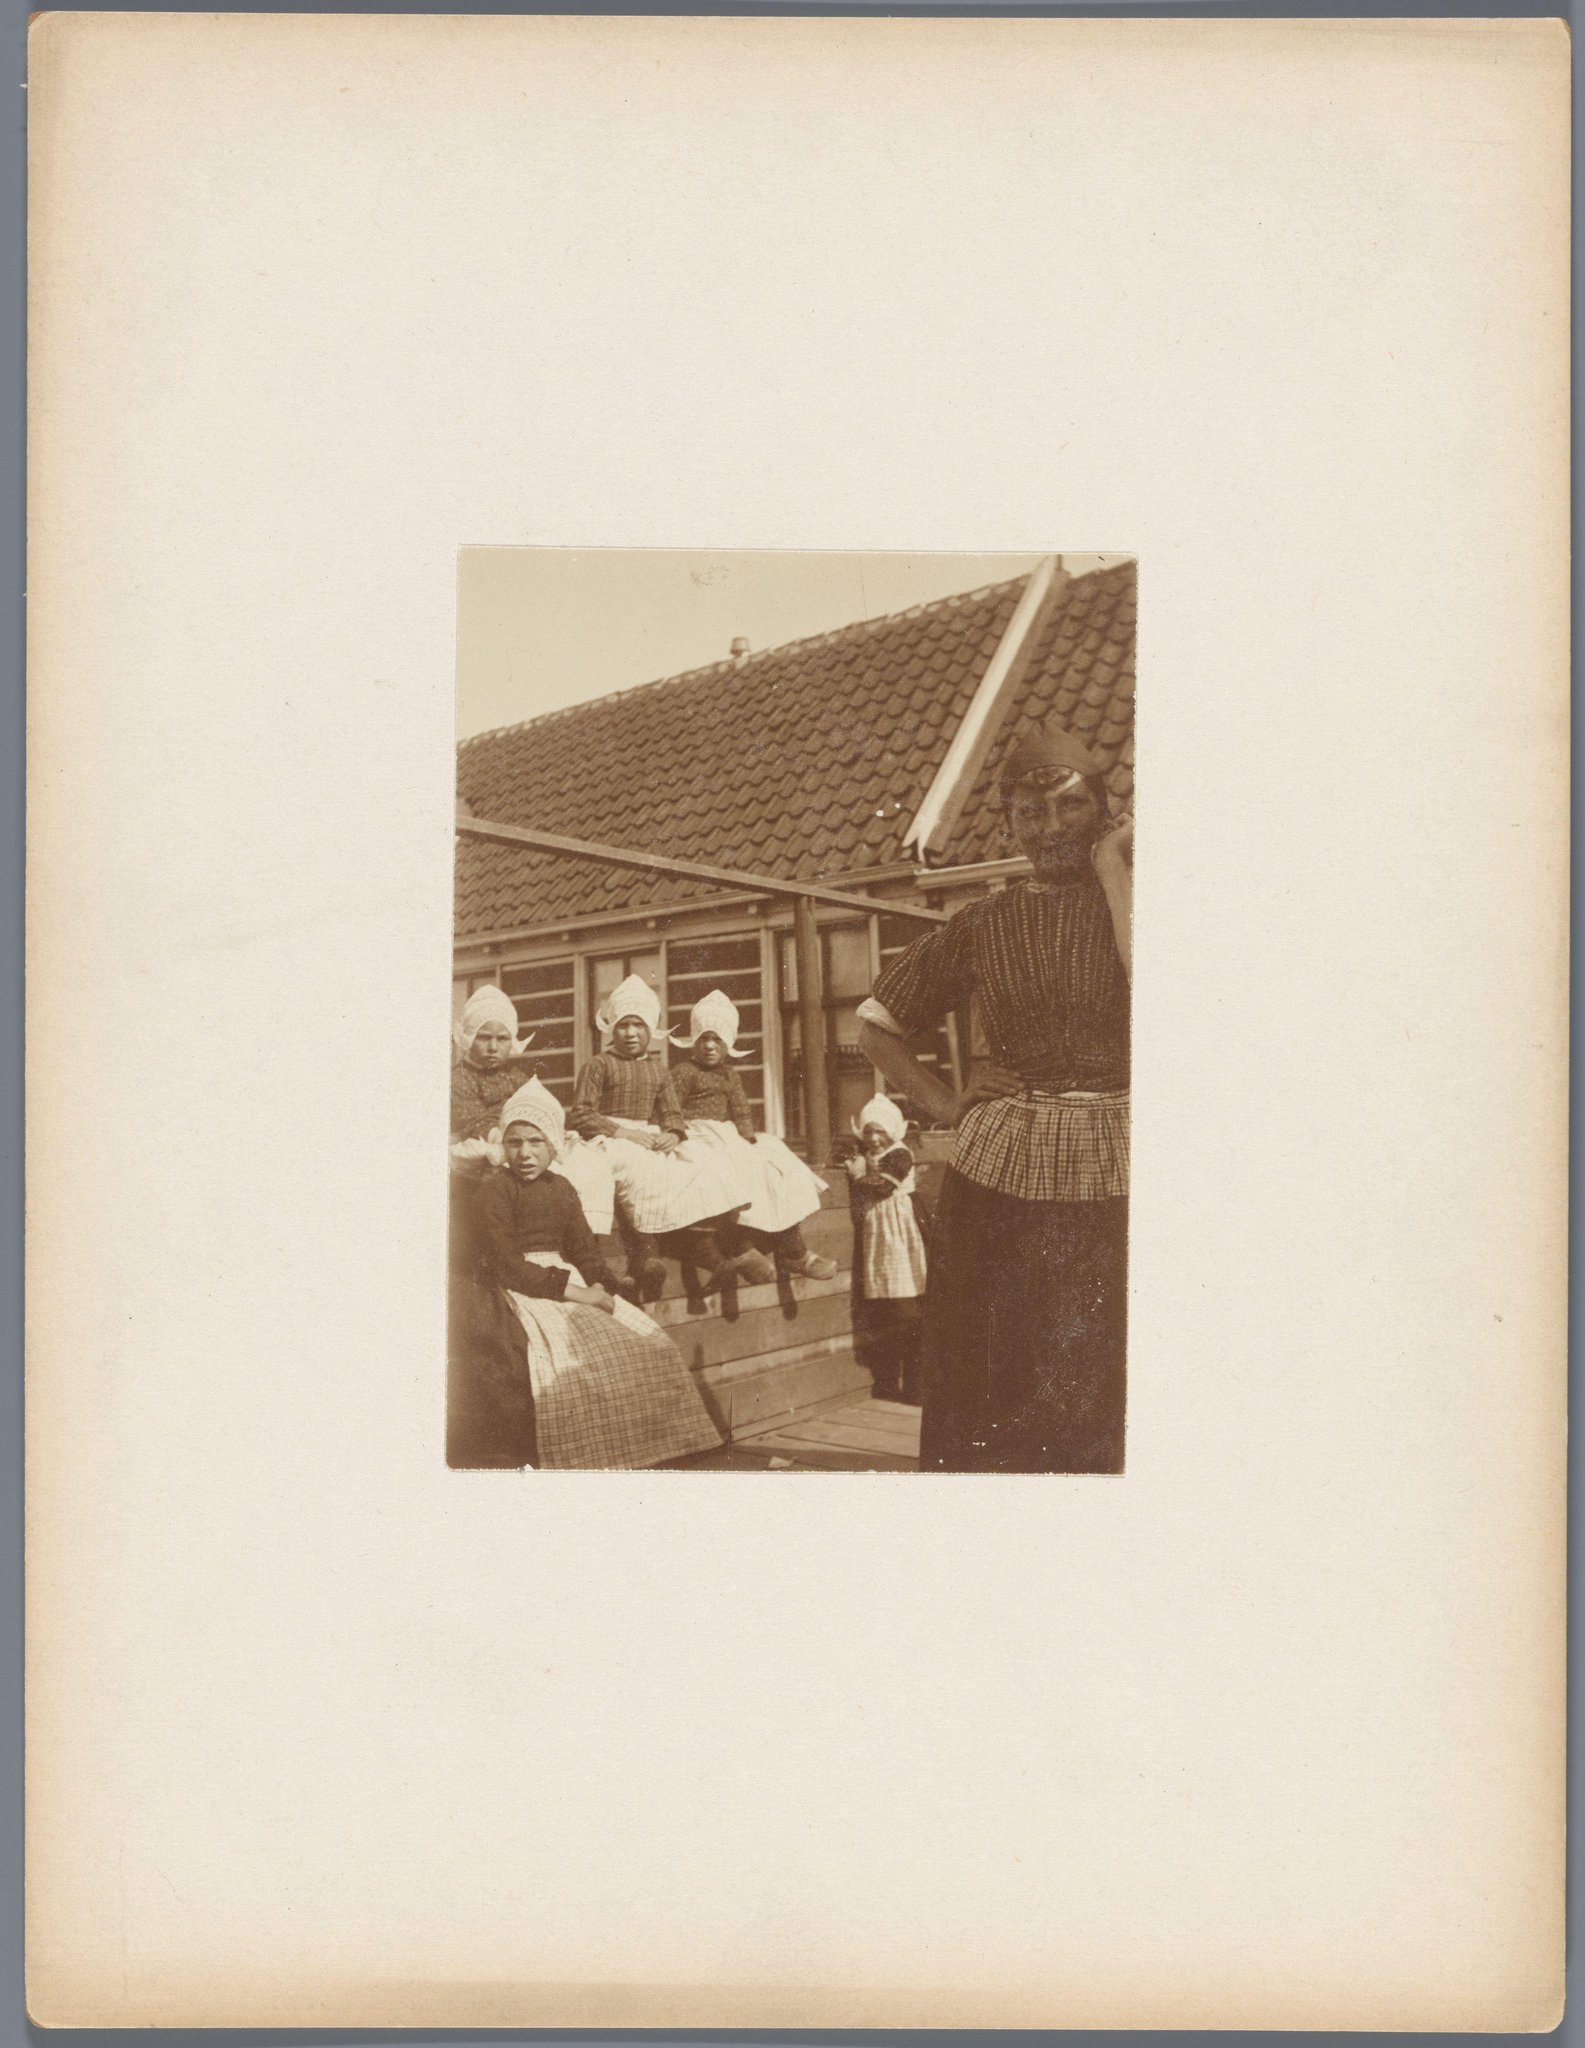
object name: photograph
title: Volendam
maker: Anonymous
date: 1907-1910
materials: cardboard, photographic support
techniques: collodion silver print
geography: volendam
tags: folk costume, regional costume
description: Vrouw met kinderen in klederdracht, Volendam. Onderdeel van het losbladige fotoalbum met 39 foto's van een reis door Nederland, ca. 1907-1910.